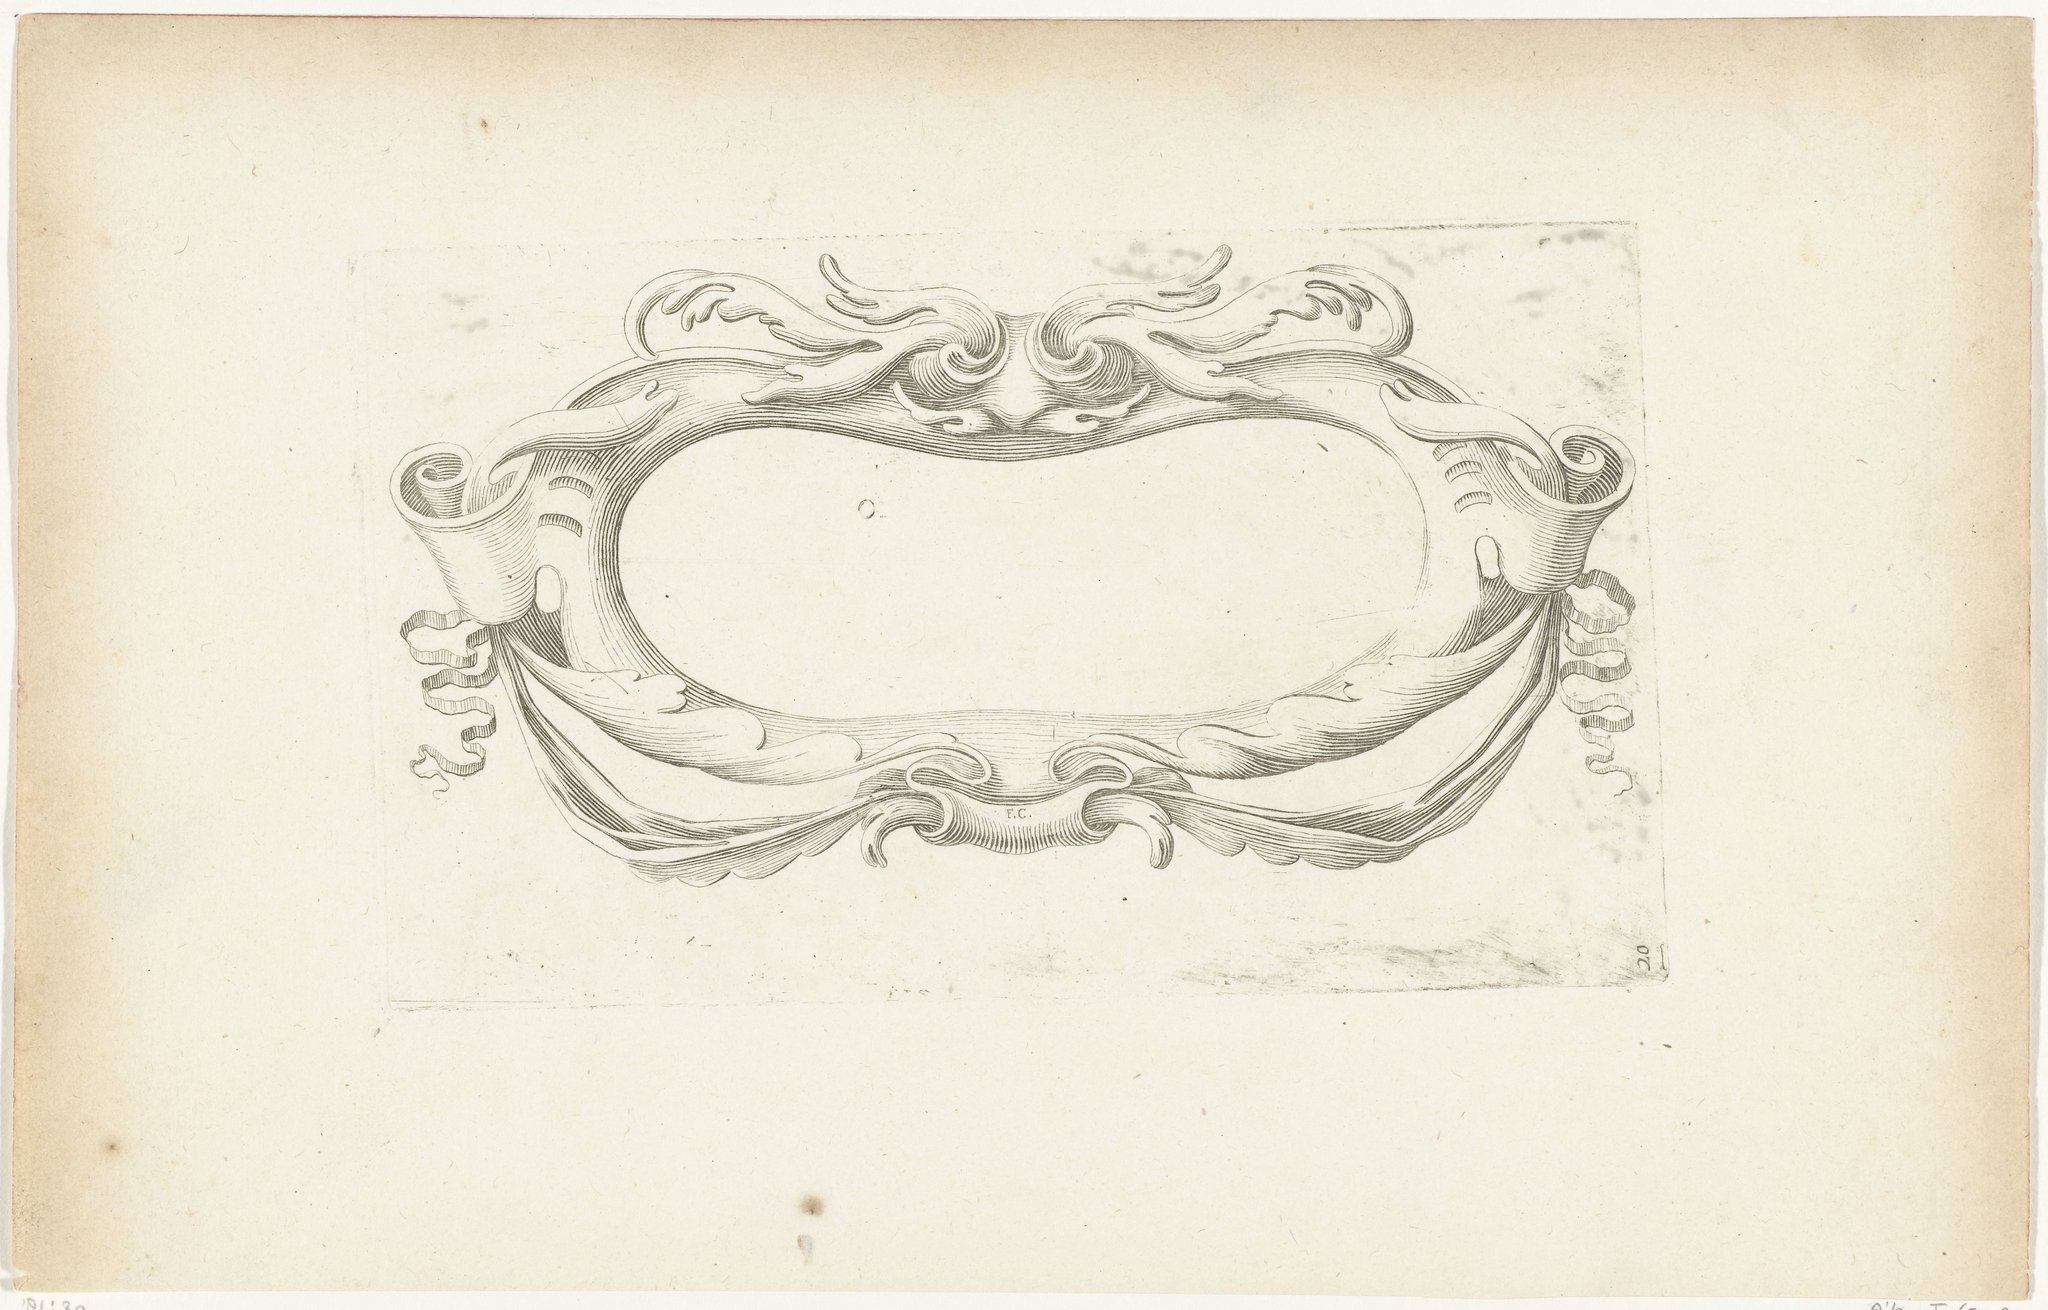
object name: ornament print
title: Cartouche met mascaron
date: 1613-1657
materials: paper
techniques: engraving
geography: france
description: In de omlijsting van rolwerk is midden boven een cartouche te herkennen. Uit zijn oogkassen komen bladranken.